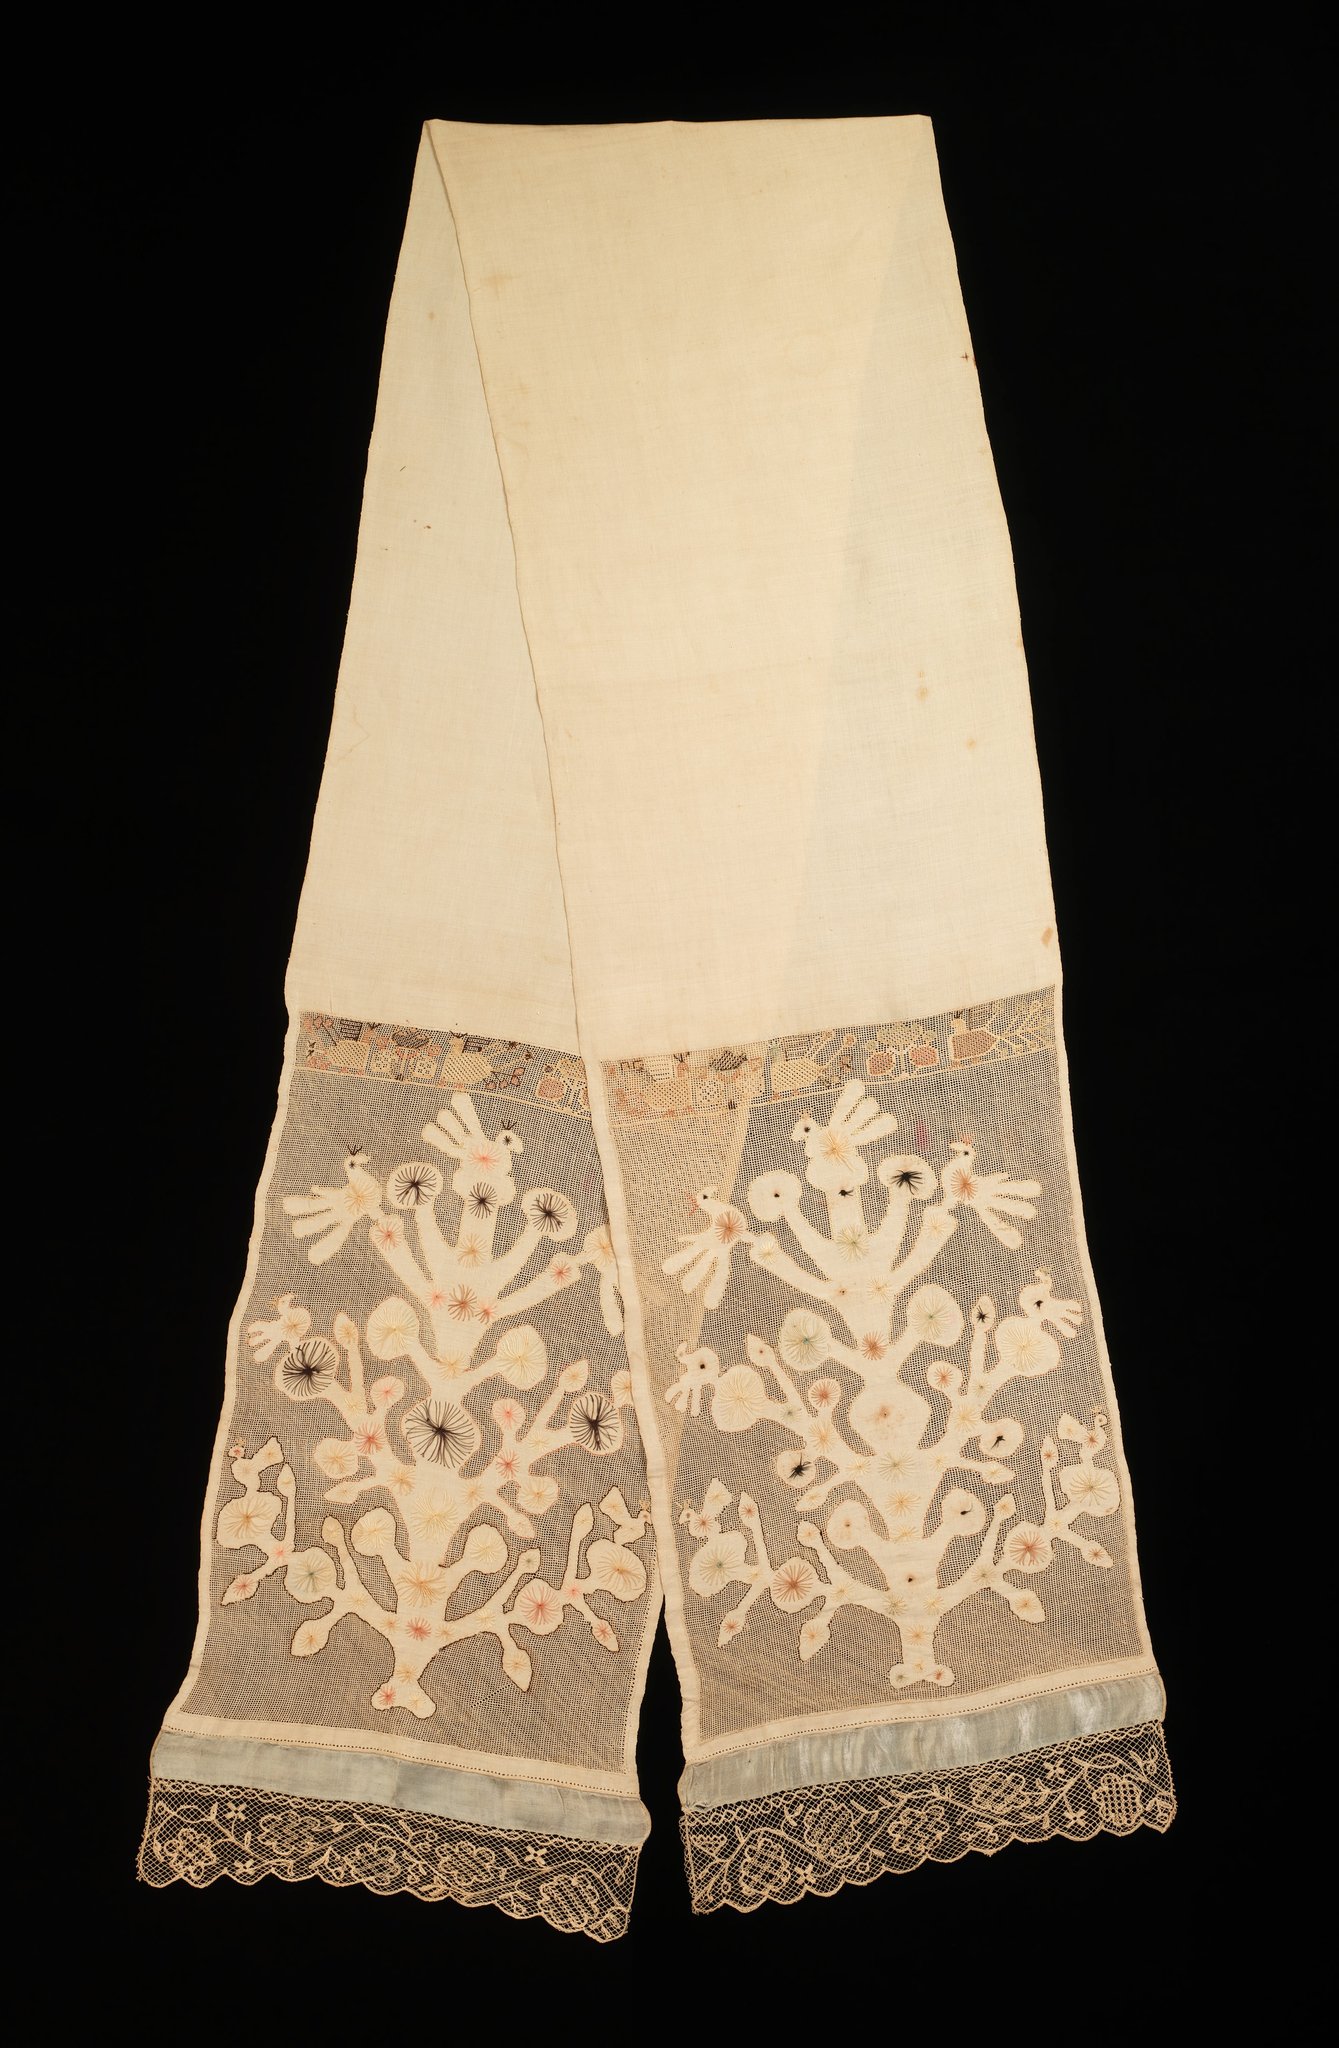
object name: towel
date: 1780-1820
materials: linen, silk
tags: birds,trees